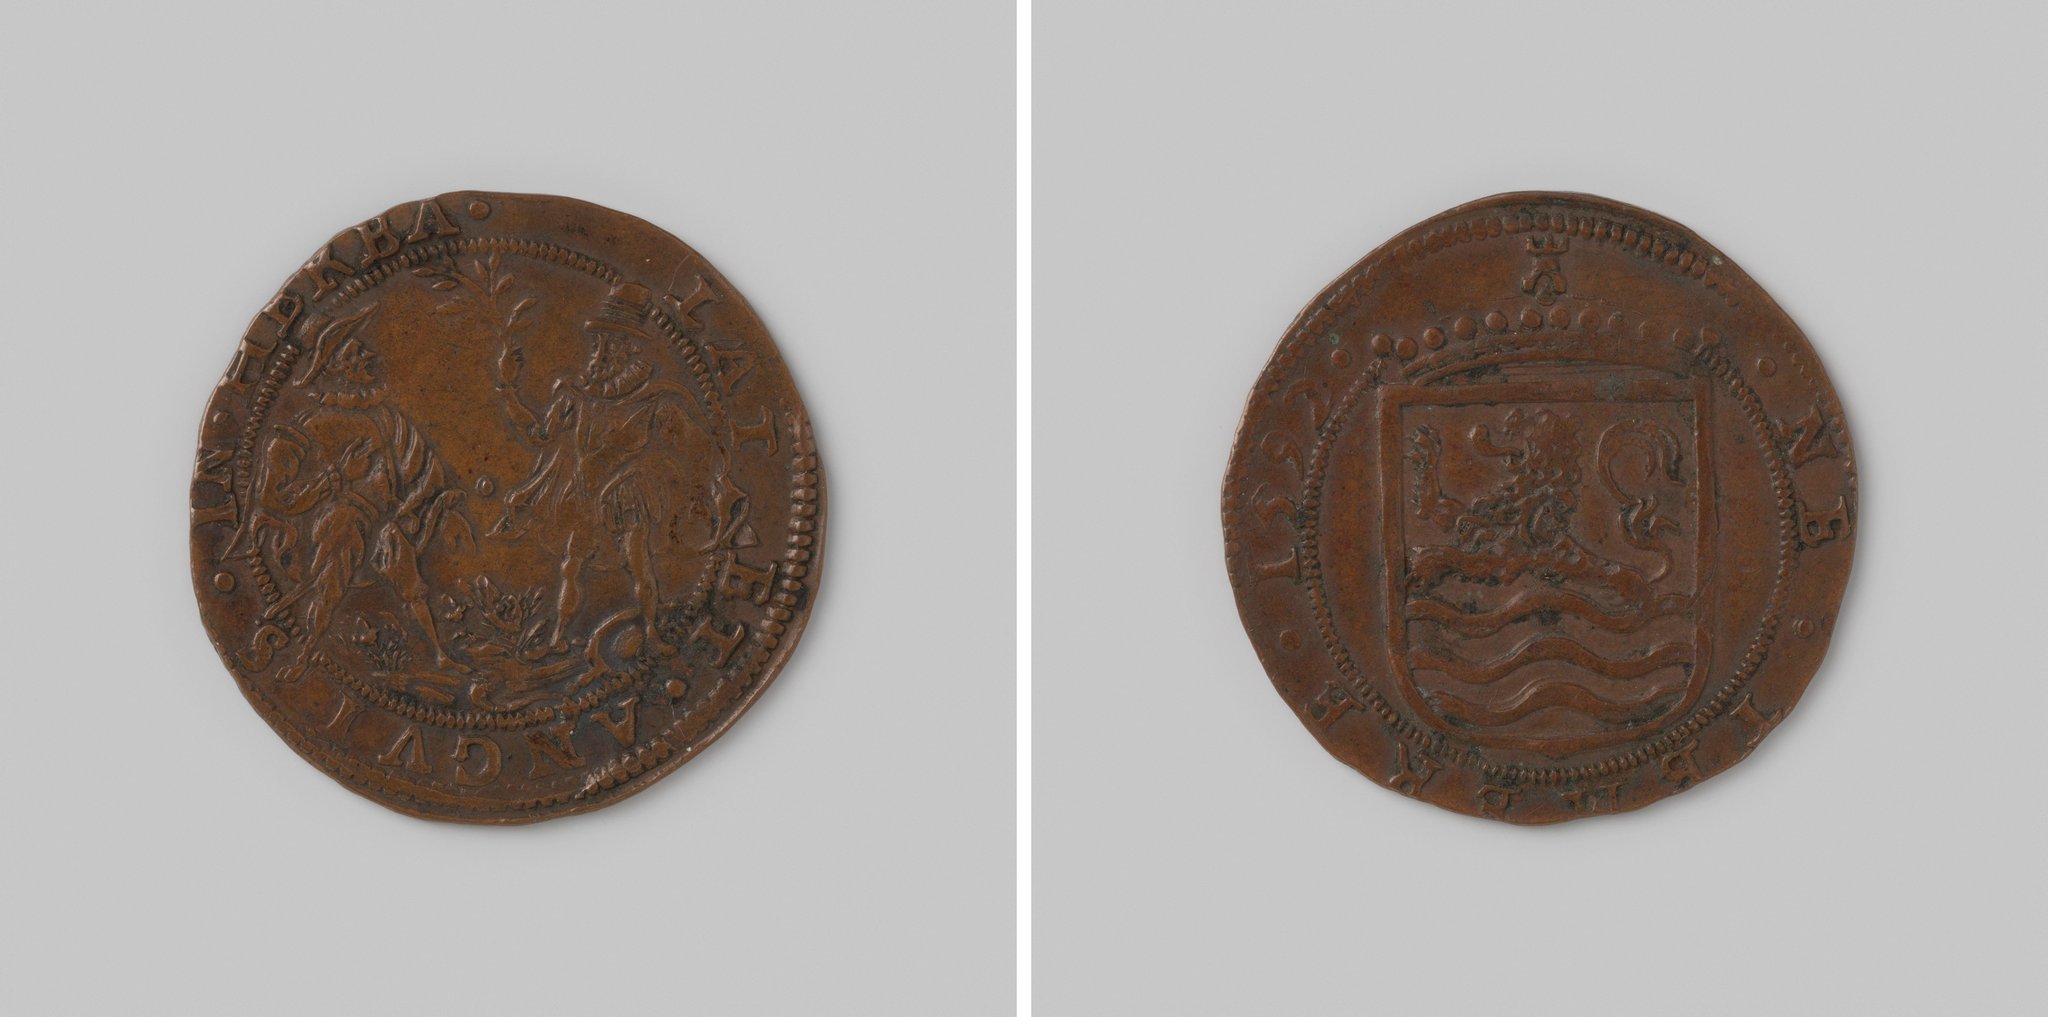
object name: jeton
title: Rekenpenning uit Middelburg op het afslaan van vredesbesprekingen 1592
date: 1592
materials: copper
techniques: striking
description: Koperen penning, op de voorzijde een Nederlander die een gezant met olijftak wijst op de slang die hem vergezelt, met omschrift, op de keerzijde het gekroonde wapenschild van Zeeland met omschrift.